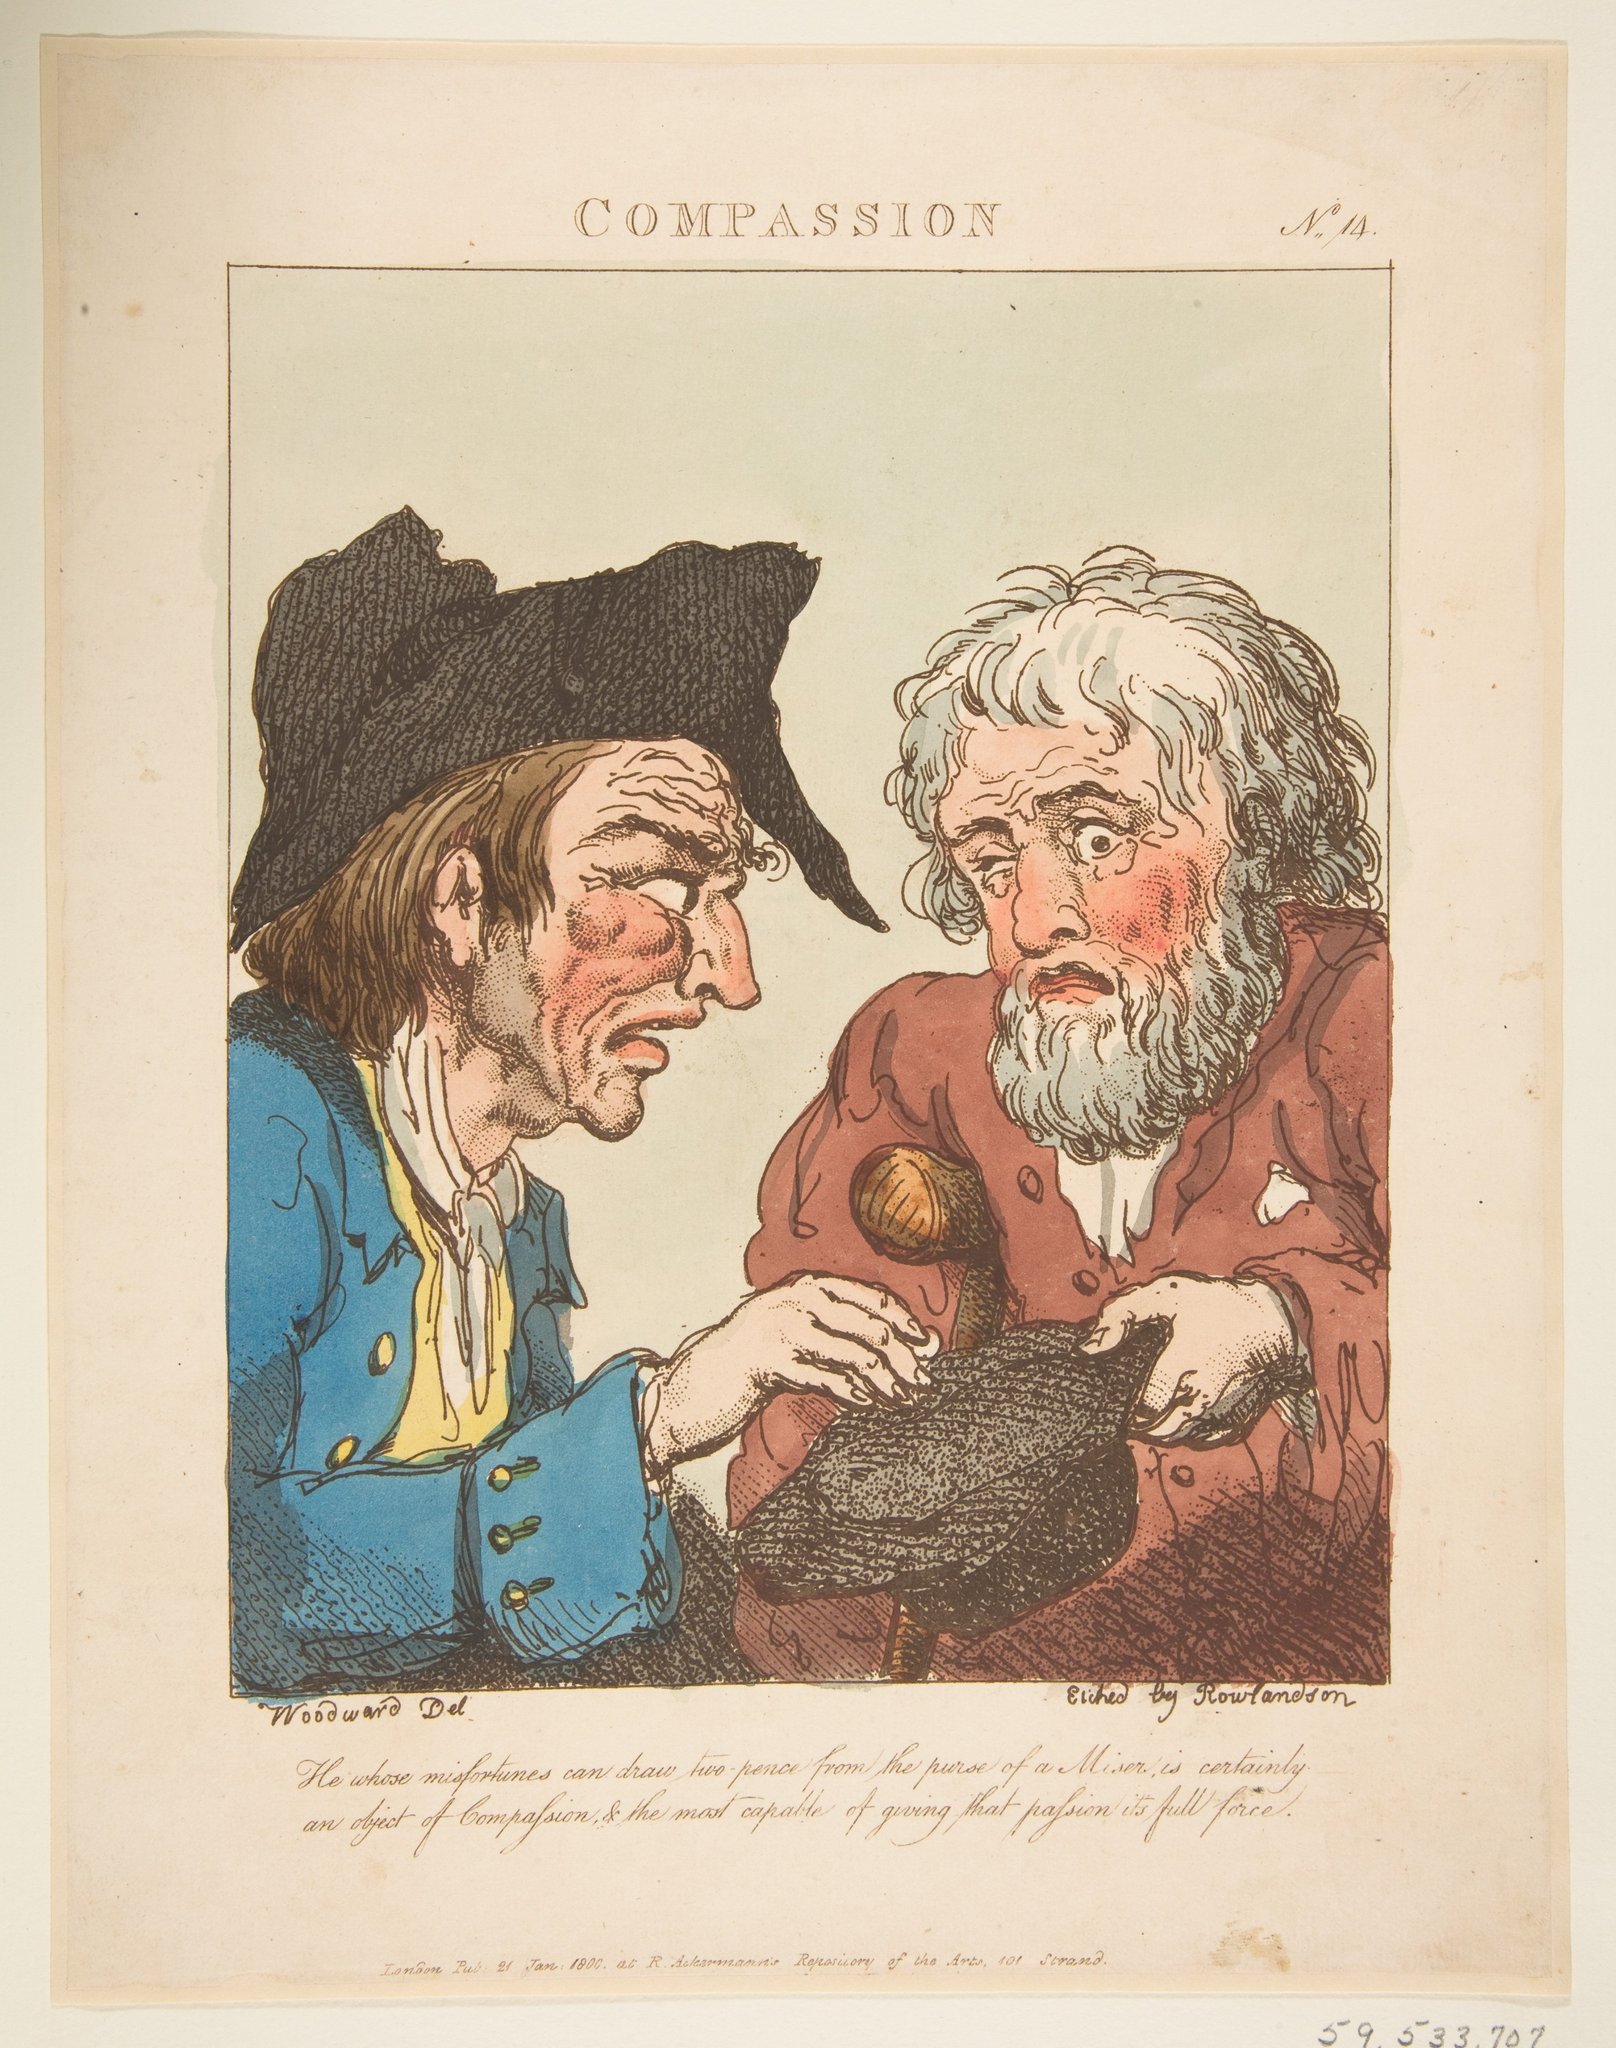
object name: print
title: Compassion (Le Brun Travested, or Caricatures of the Passions)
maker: thomas rowlandson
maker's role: artist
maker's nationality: british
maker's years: 1757-1827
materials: ink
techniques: etching, printing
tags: men